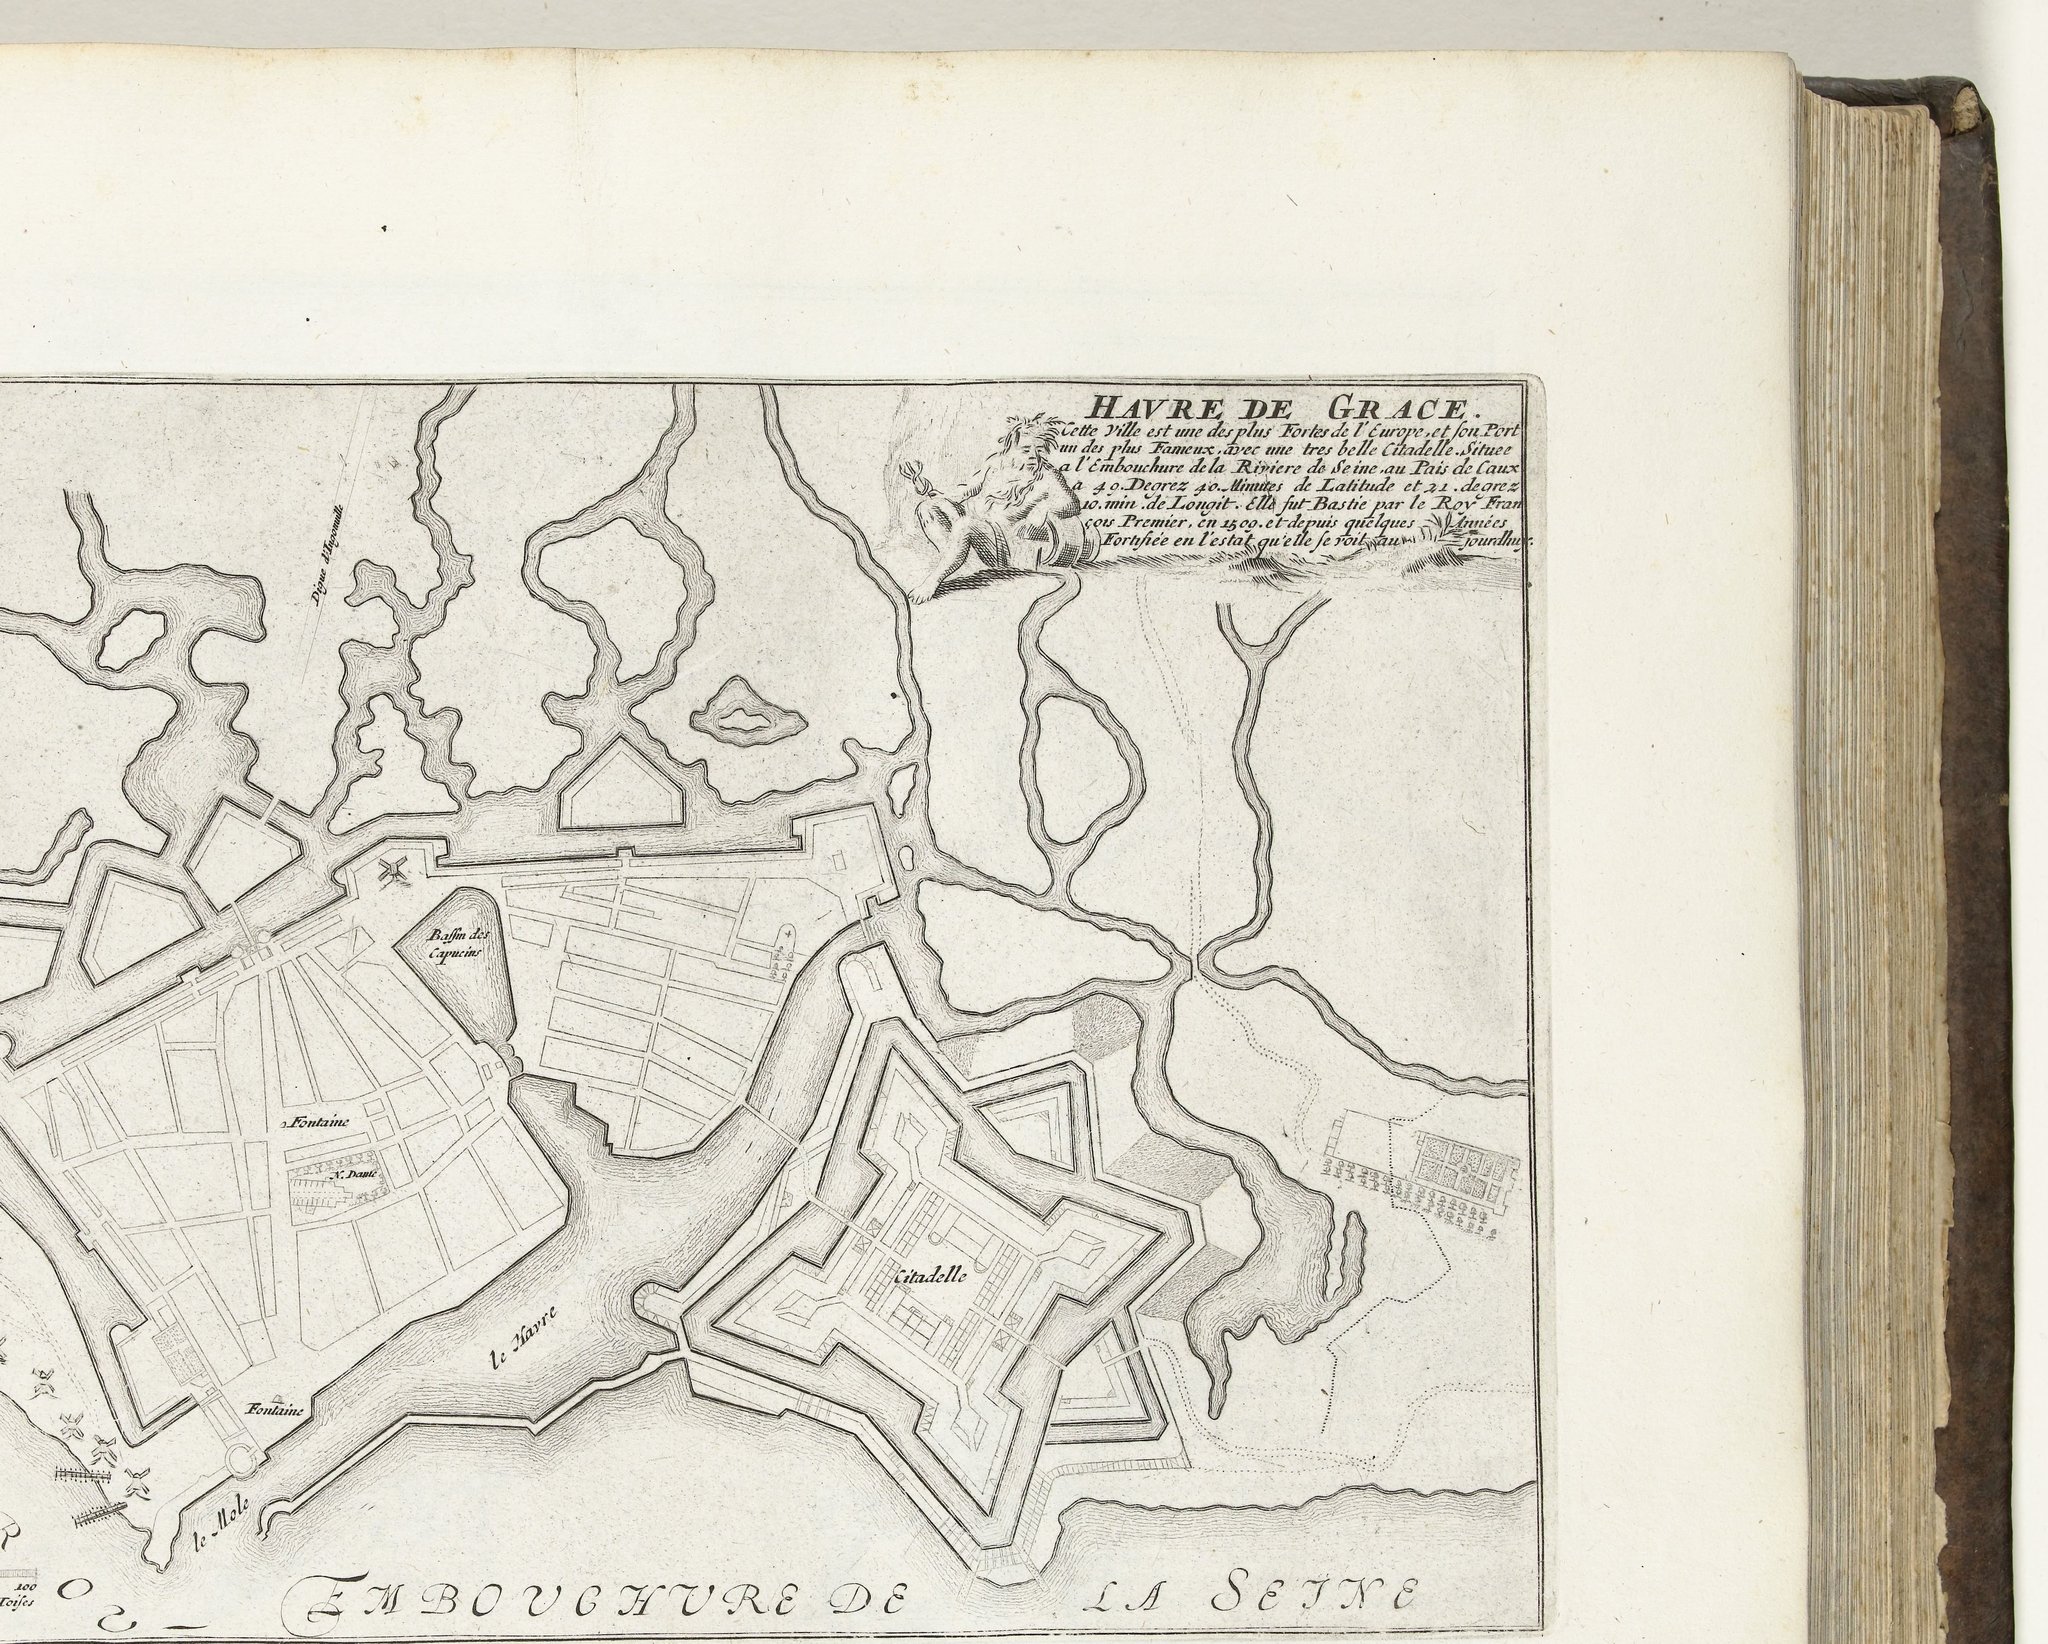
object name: map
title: Les forces de l'Europe, ou description des principales villes, avec leurs fortifications : dessignées par les meilleurs ingenieurs, particulierement celles (...) de la France, dont les plans ont esté levez par M. de Vauban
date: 1693-1695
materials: paper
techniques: engraving, etching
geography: france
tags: fortress, maps of cities, le havre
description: Plattegrond van de versterkingen om de Franse stad Le Havre. Onderdeel van het derde deel (1695) van het prentwerk waarin gebundeld zijn de acht delen van Les forces de l'Europe uitgegeven tussen 1693-1697. Het prentwerk bestaat uit 175 platen met plannen (afkomstig van Sébastien Le Prestre, Seigneur de Vauban) van vermaarde sterke steden en vestingen in de Negenjarige Oorlog. Titel en opschriften in het Frans.